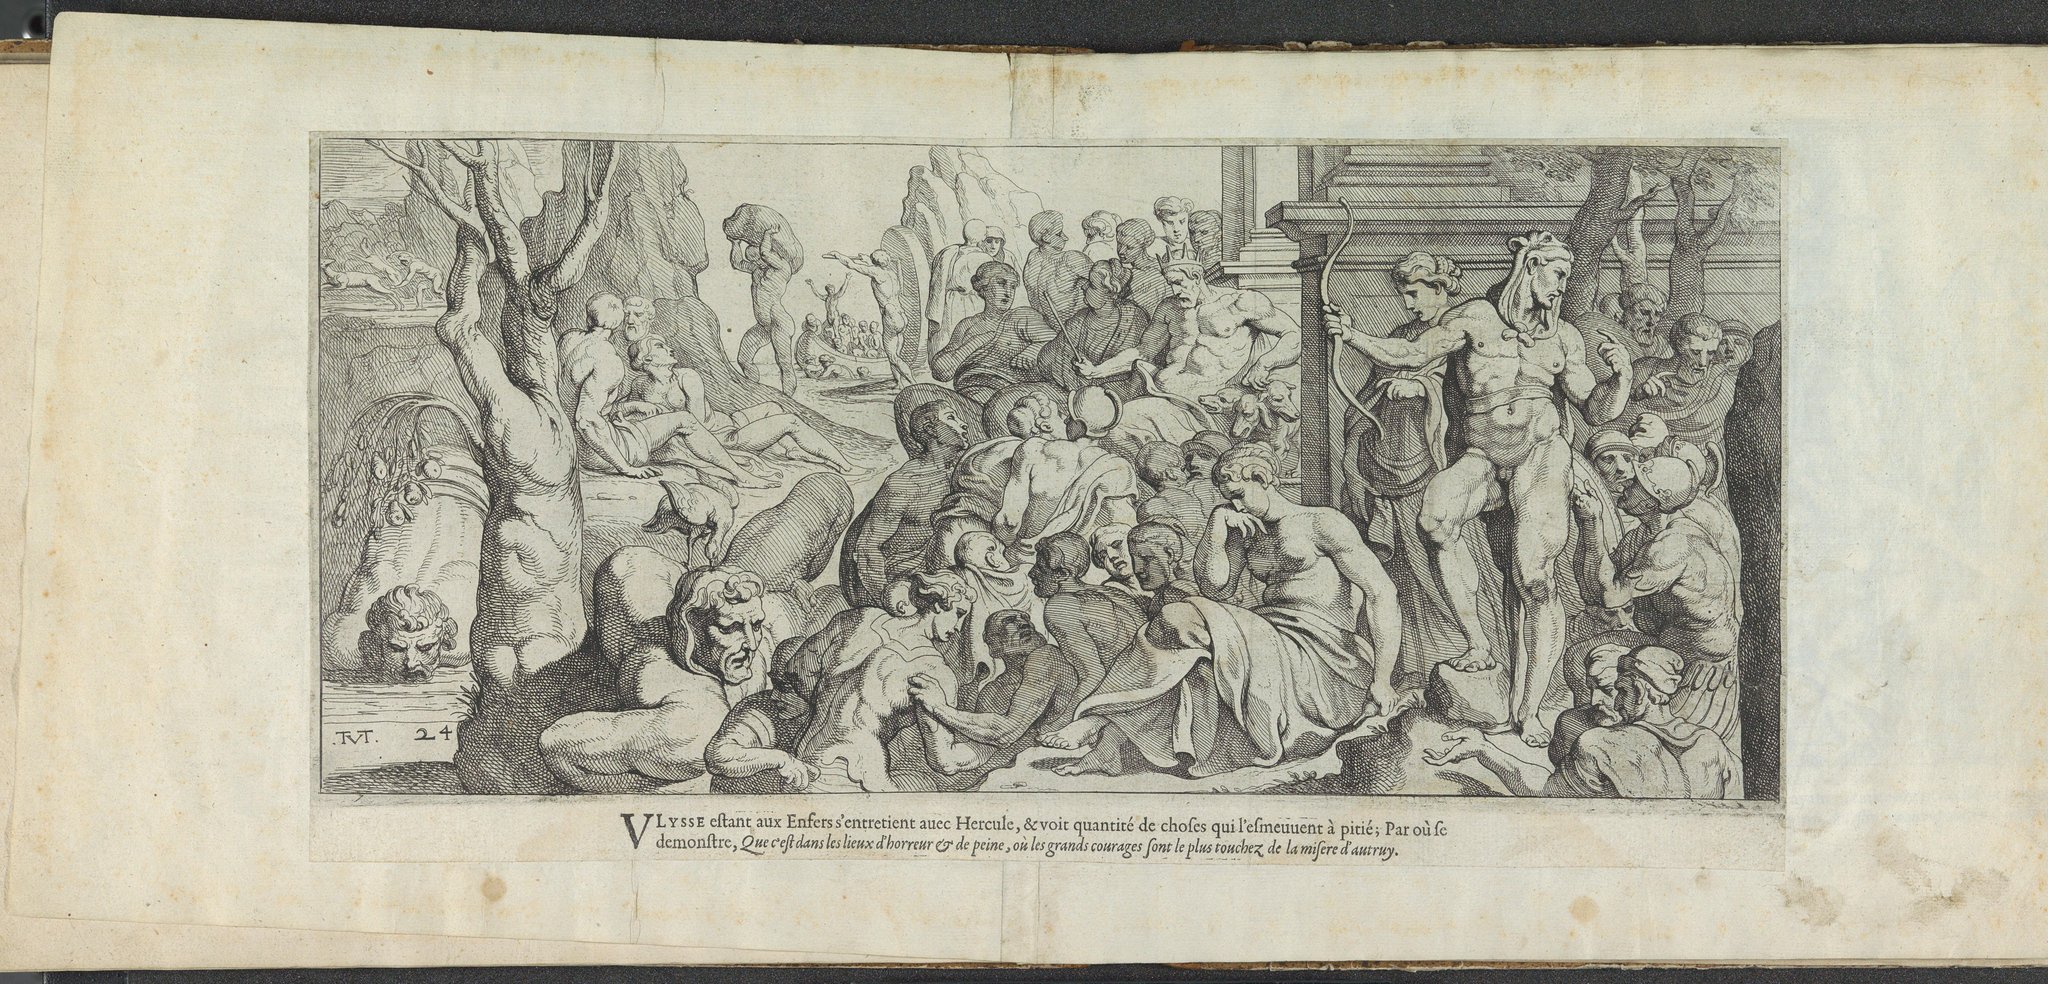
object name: album leaf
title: De werken van Odysseus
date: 1633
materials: paper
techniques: engraving, etching, letterpress printing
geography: paris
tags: ulysses meets the ghosts of numerous queens, princesses, heroes, comrades, including his mother anticlea, (story of) tantalus, (story of) sisyphus, tityus; two vultures (or an eagle) tearing at his liver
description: Odysseus op bezoek in de onderwereld. In het midden zit Hades, de heerser van de onderwereld, met de driekoppige hond Cerberus. Rechts ontmoet Odysseus de held Hercules. Links drie figuren die voor uiteenlopende misdaden hun straf ondergingen in de Tartarus: Tantalus, Sisyphus en Tityus. De prent maakt deel uit van een album.